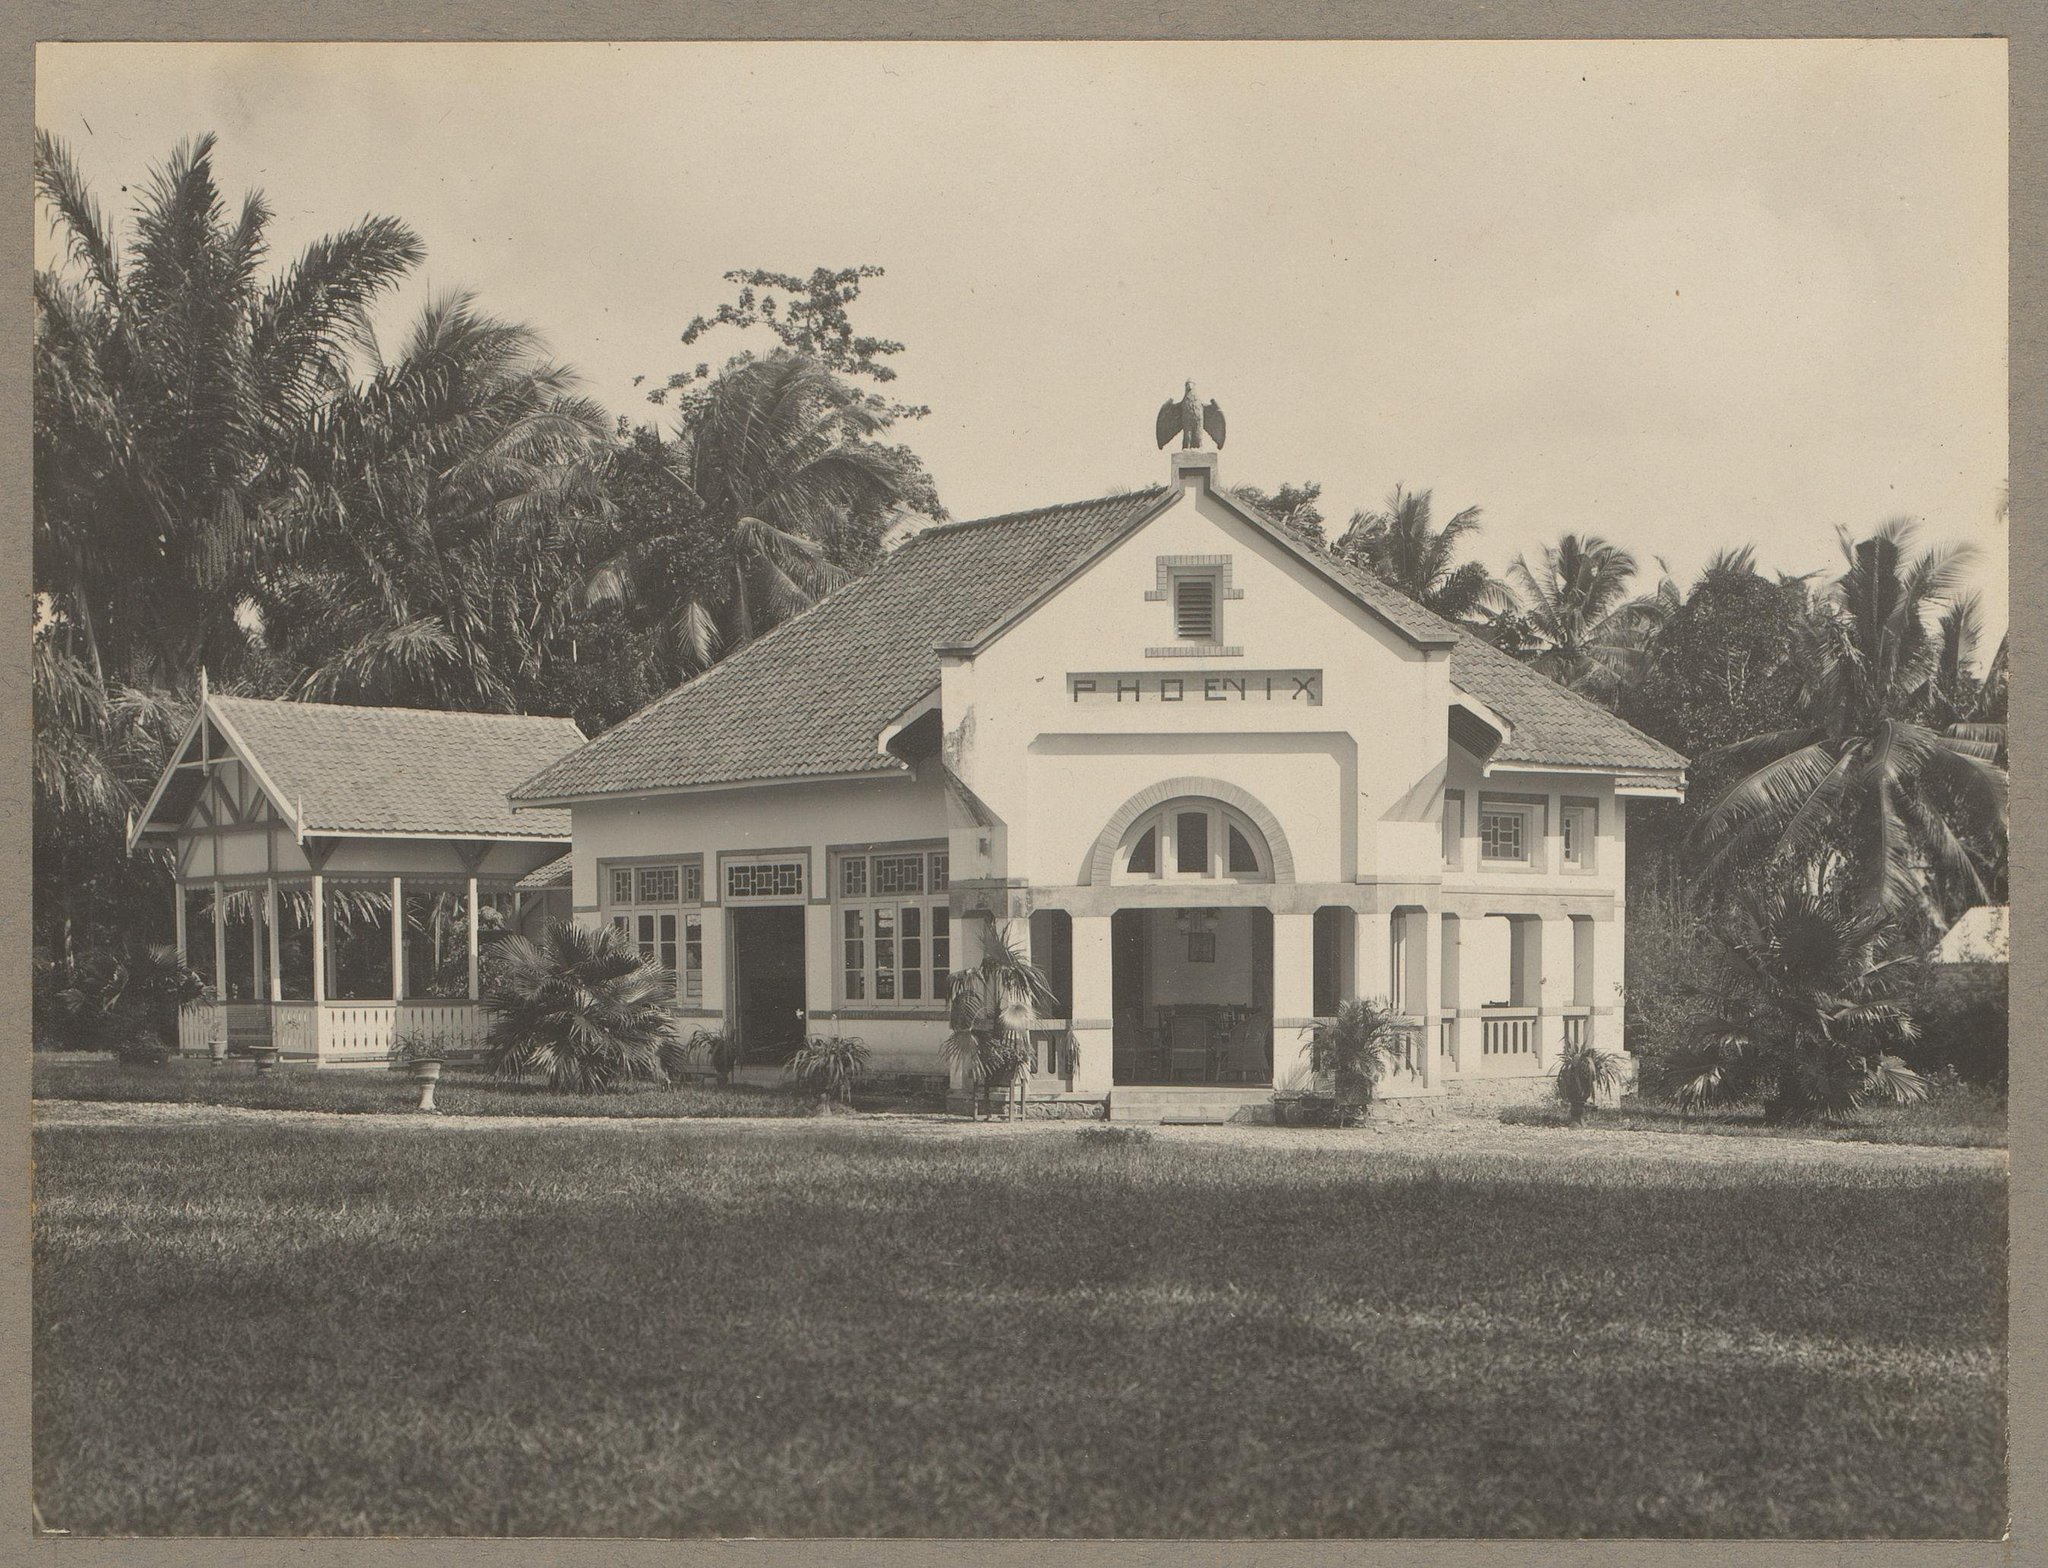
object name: photograph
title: Societeit Phoenix Soengeiliat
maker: Anonymous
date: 1914-1919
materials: photographic support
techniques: gelatin silver print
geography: bangka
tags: robert julius boers, colonial system, club, meeting place, mining, detached house in city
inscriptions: inscription: ‘Societeit Phoenix Soengeiliat’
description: Het gebouw van de Sociëteit Phoenix van de Banka-tinwinning te Soengeiliat-Moerawang (Soengai Merawang). Onderdeel van het fotoalbum aangeboden aan Robert Julius Boers bij zijn vertrek naar Nederland in 1919 door het personeel van de Banka-tinwinning.